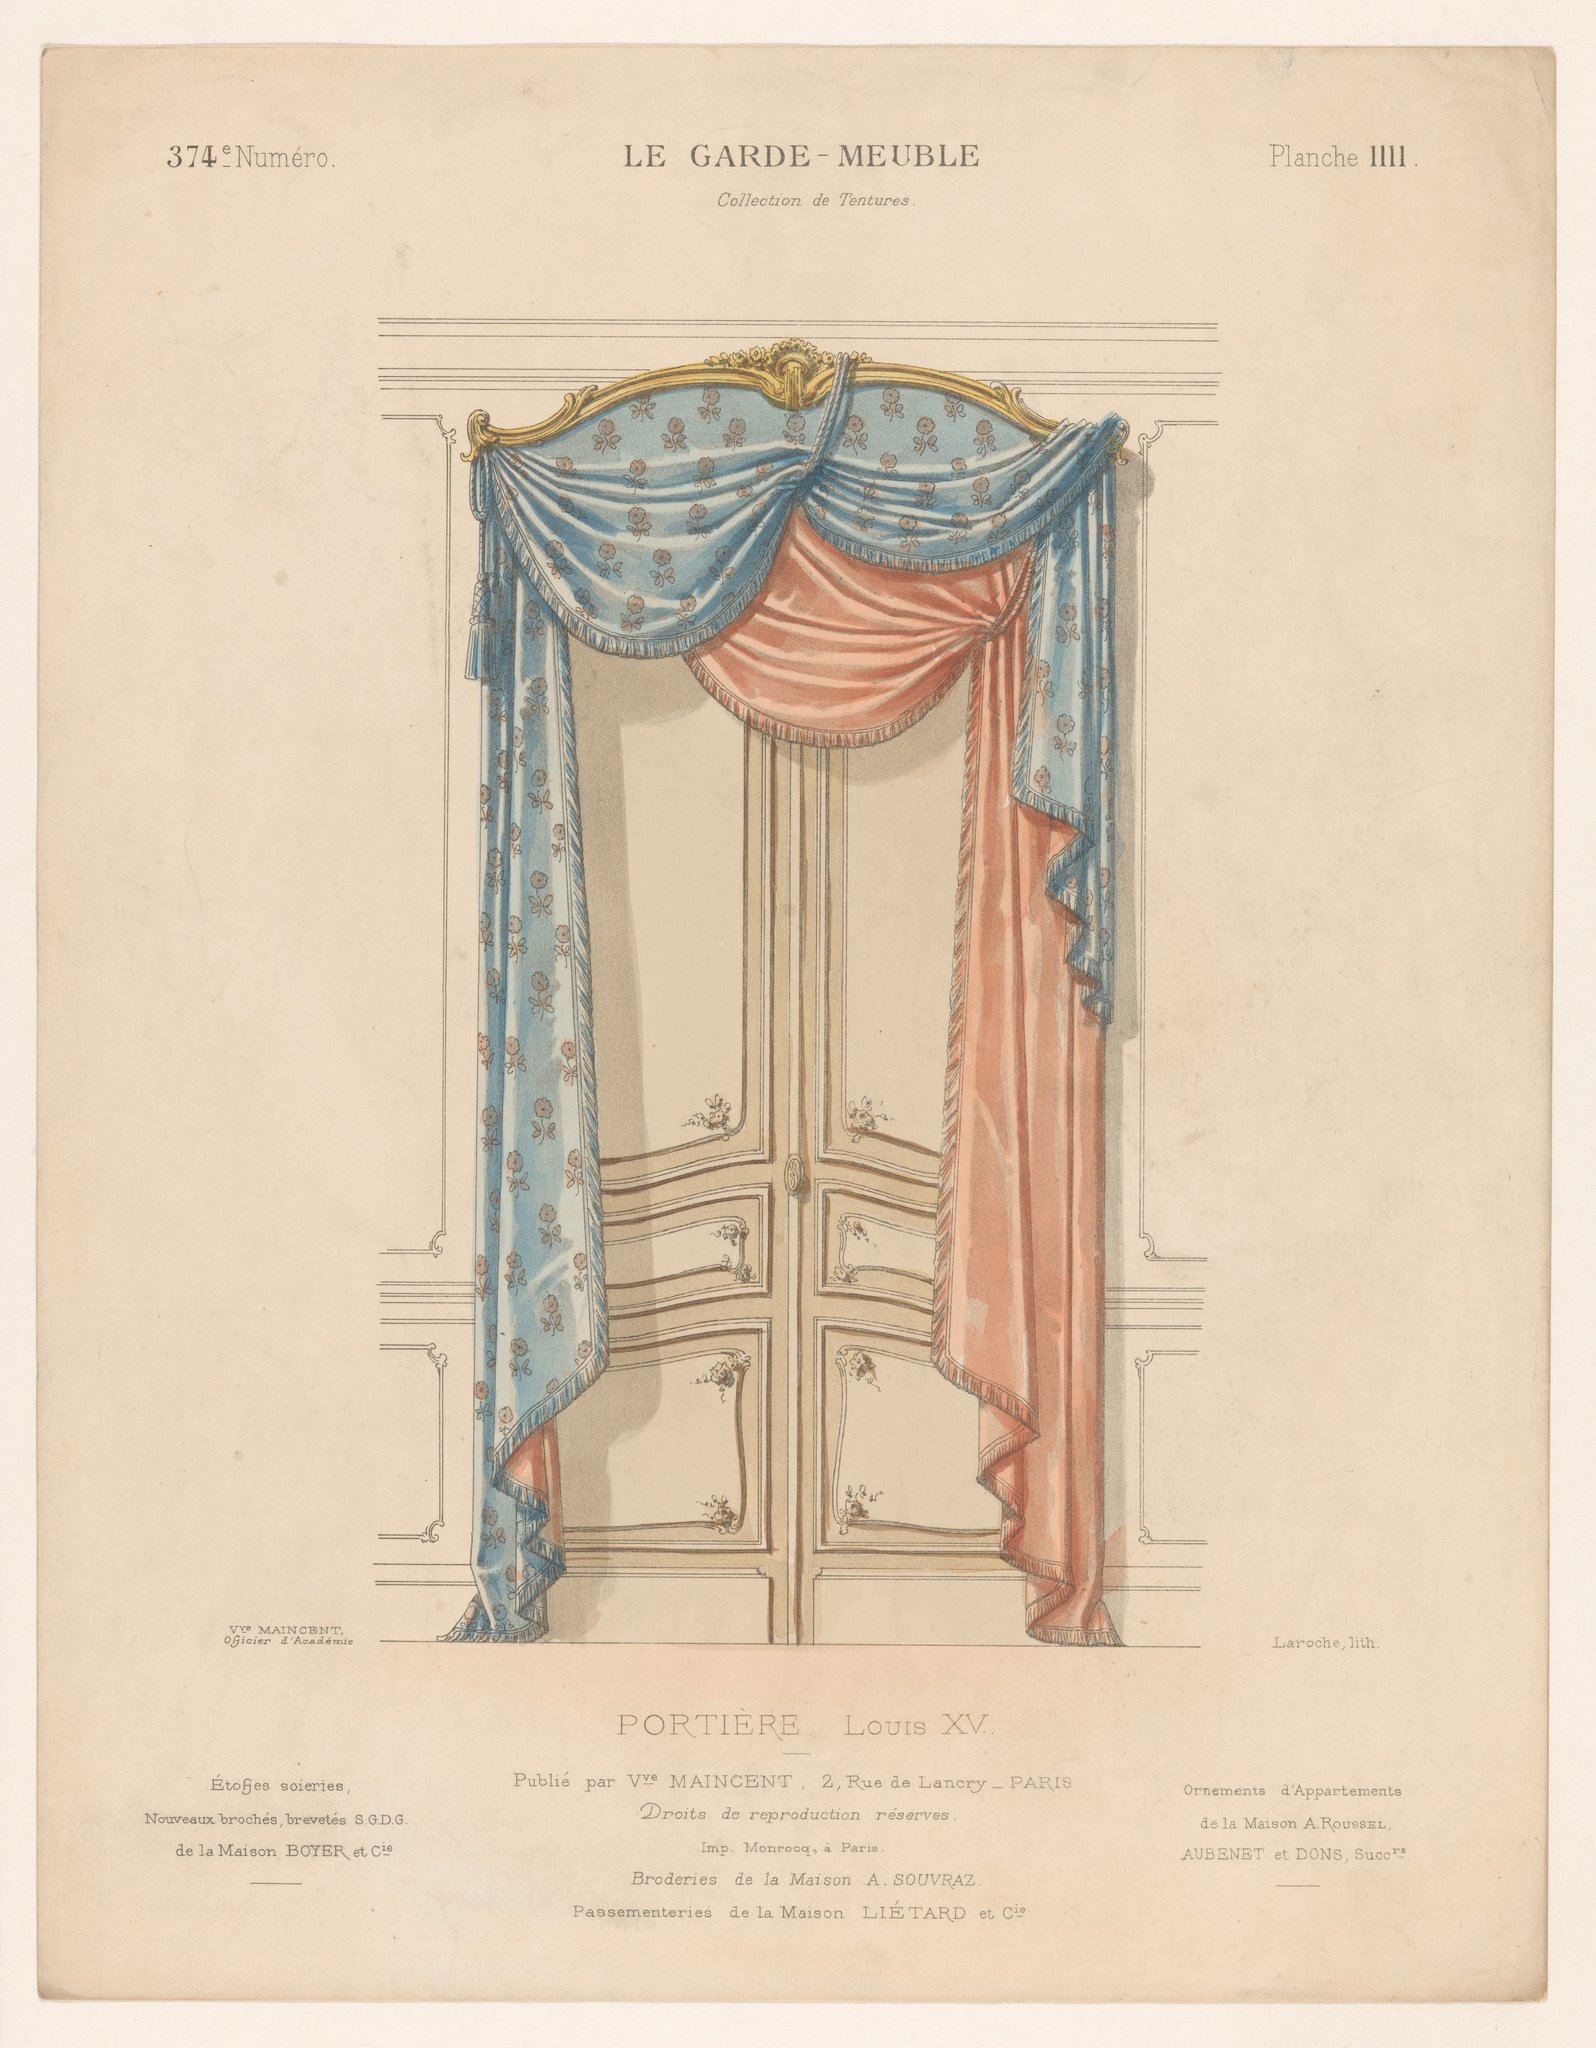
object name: print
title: Portière, Louis XV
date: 1895-1910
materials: paper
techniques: hand coloring, lithograph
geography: paris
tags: door, hangings and drapery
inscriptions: : ‘Droits de reproduction réservés.’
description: Deur met gedrapeerde gordijnen in de Lodewijk XV-stijl. Prent uit 374e Livraison.